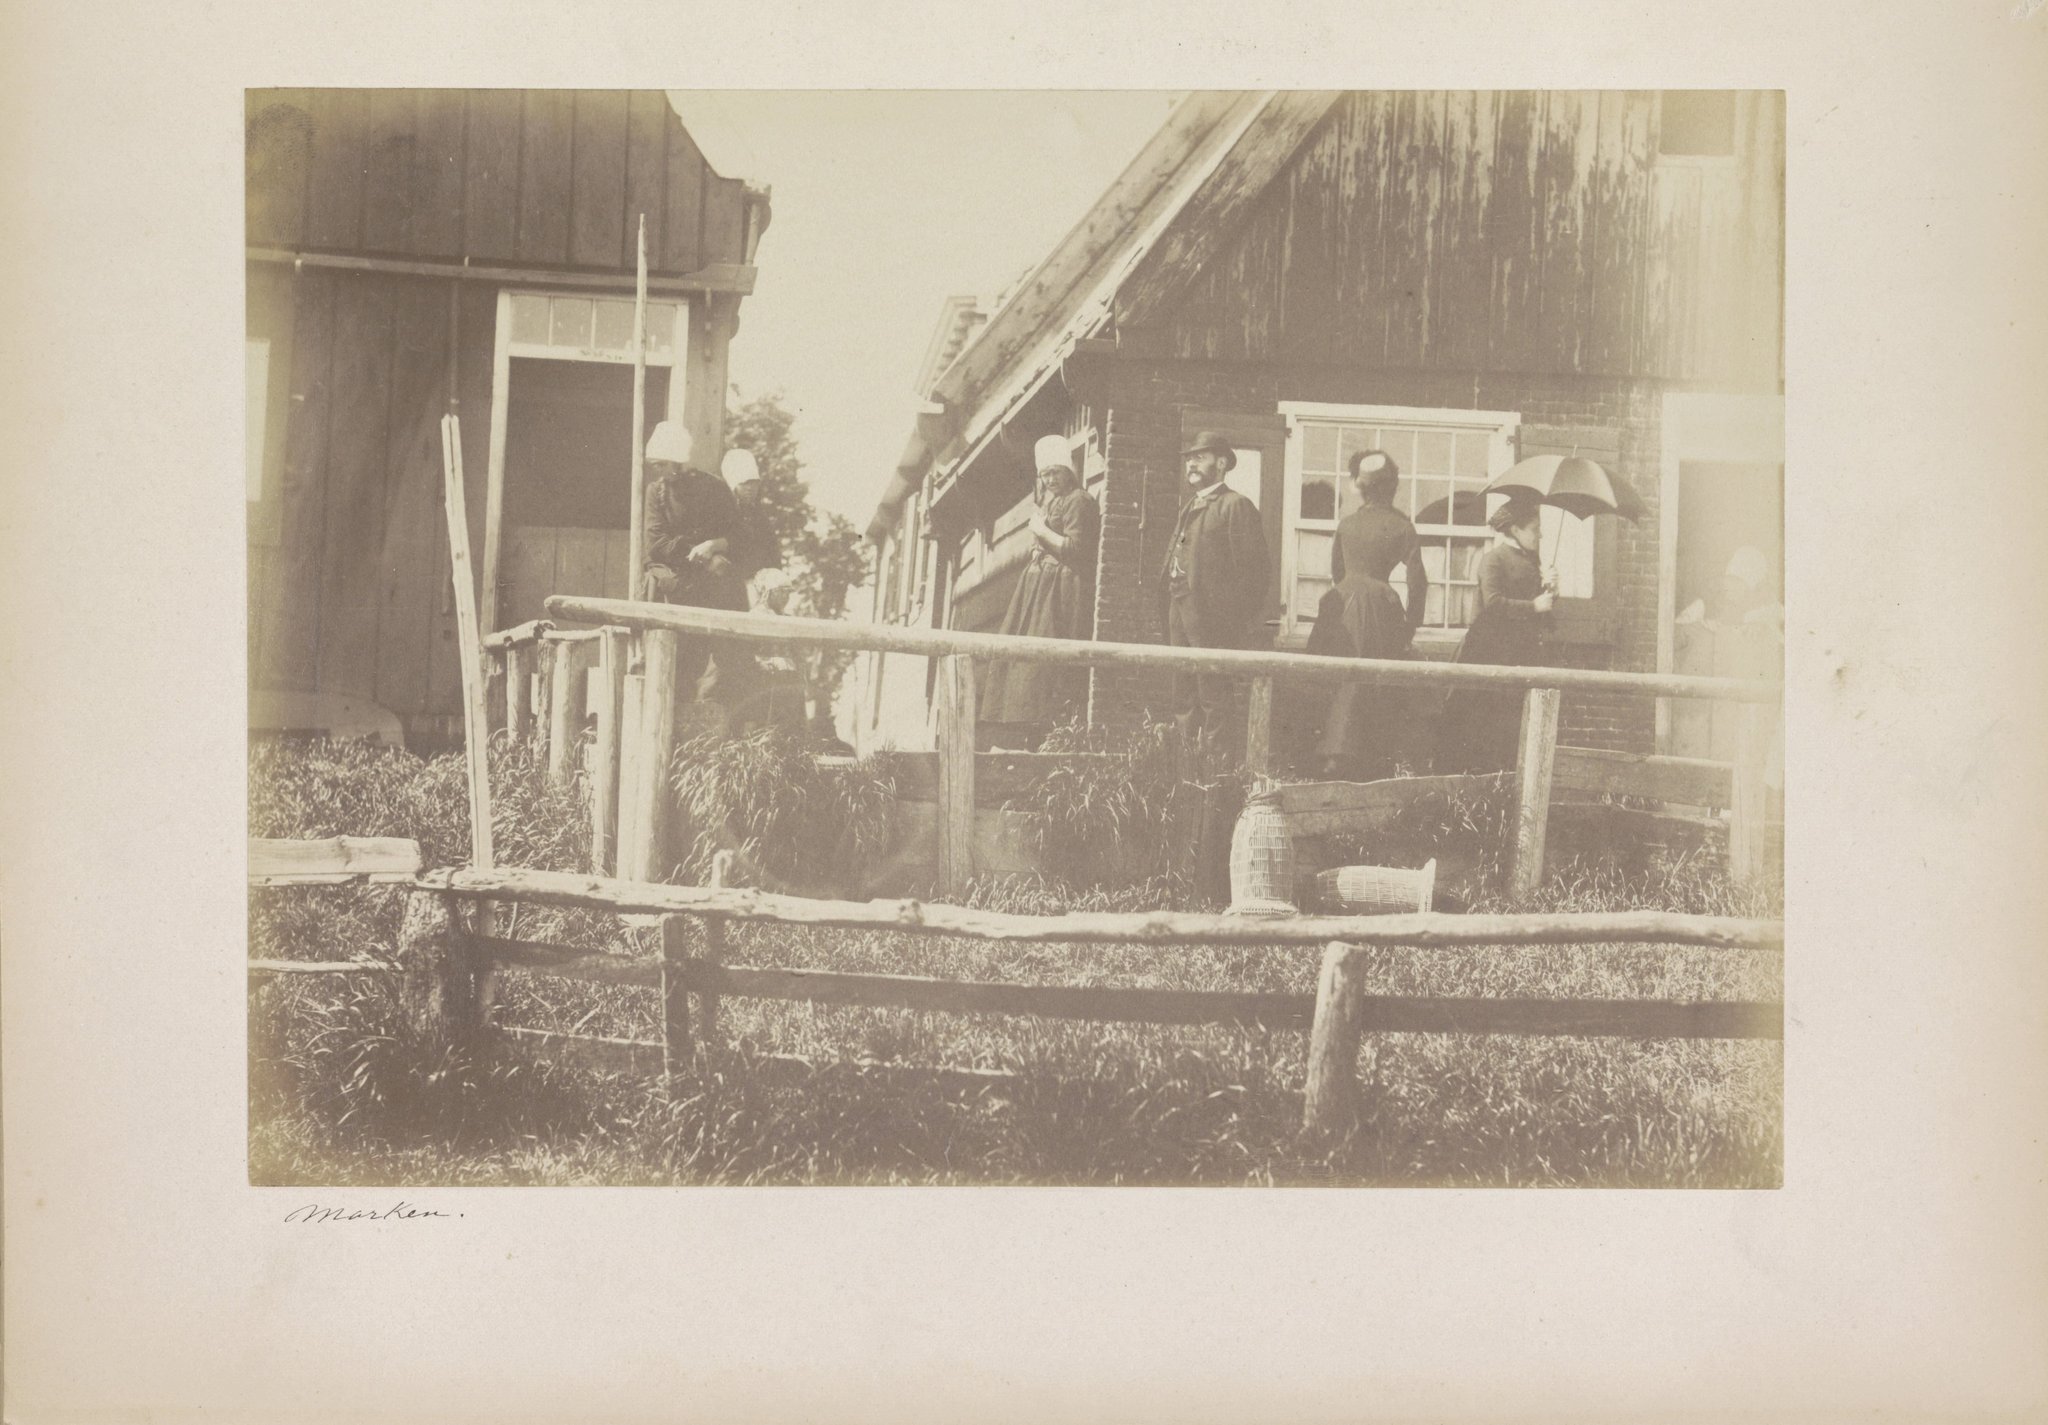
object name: photograph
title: Marken Hollande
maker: Anonymous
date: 1885-1900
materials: paper, photographic support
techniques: albumen print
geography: marken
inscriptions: annotation: ‘(Hollande)’, annotation: ‘Marken’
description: Meisjes in klederdracht en enkele lieden van het reisgezelschap (een man en twee vrouwen, waarvan er een met een parasol) bij twee huizen op een dijk op Marken.